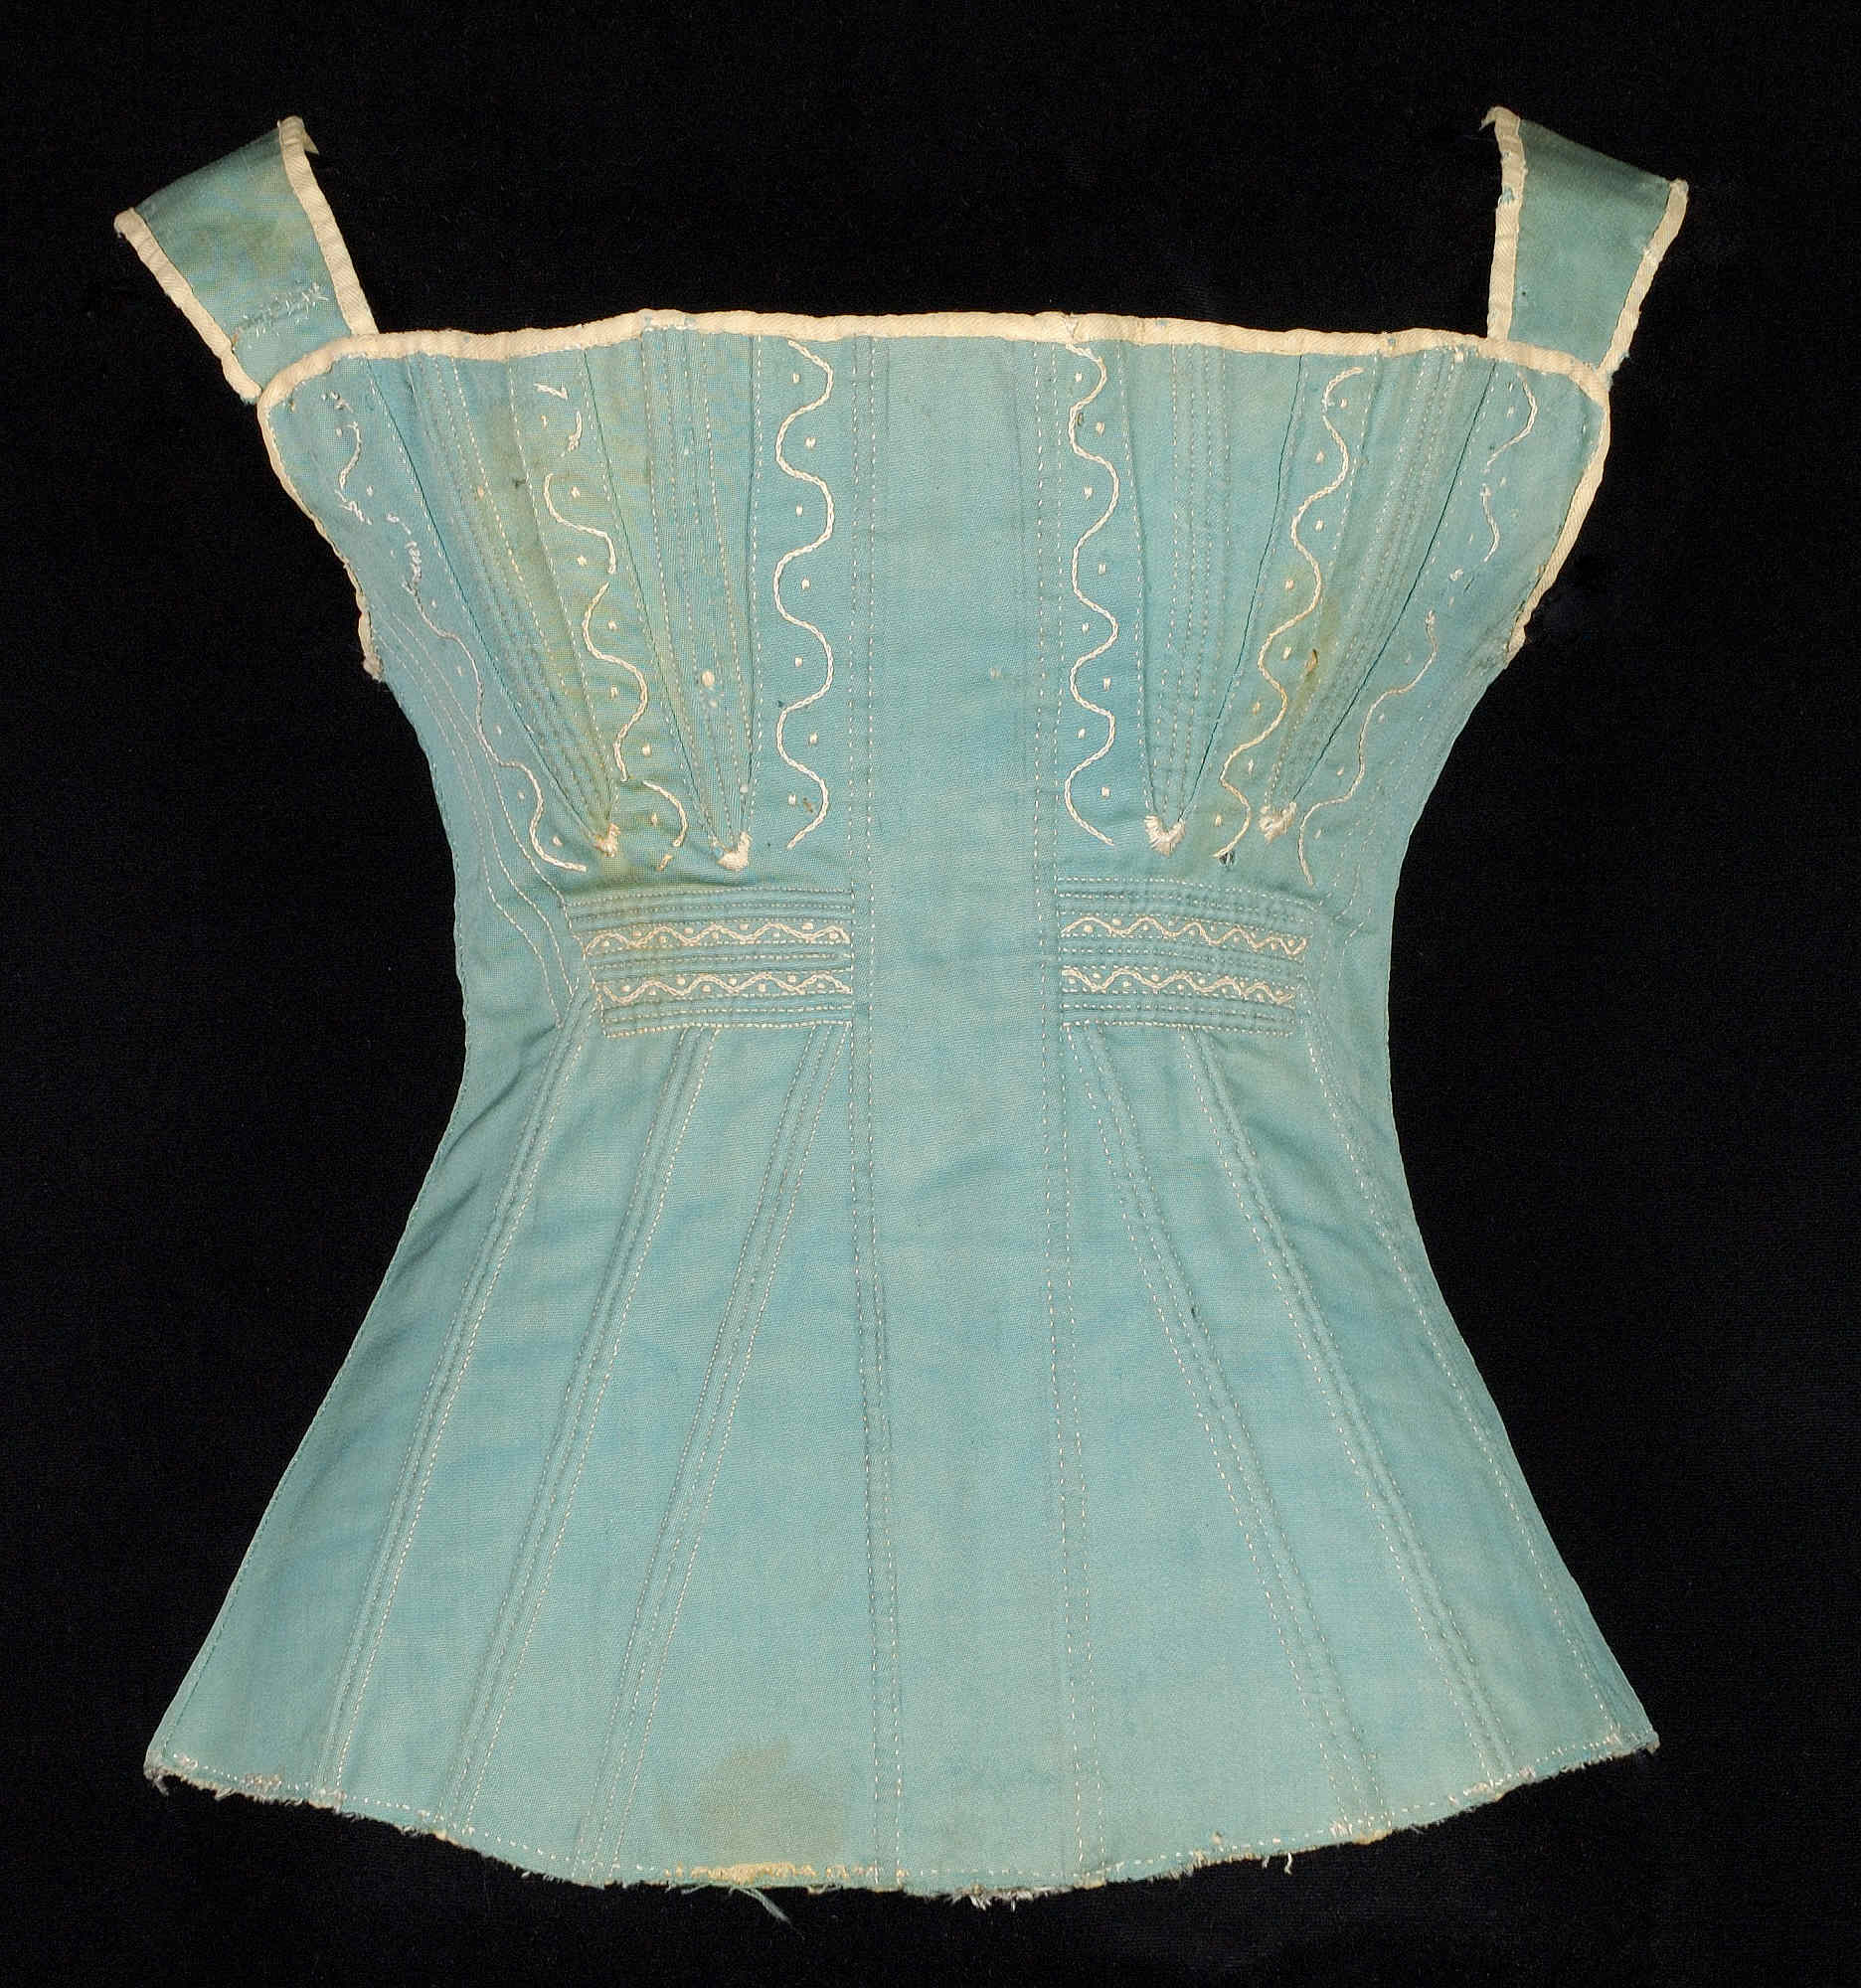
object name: stay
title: Stays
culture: american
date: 1825-1835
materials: cotton